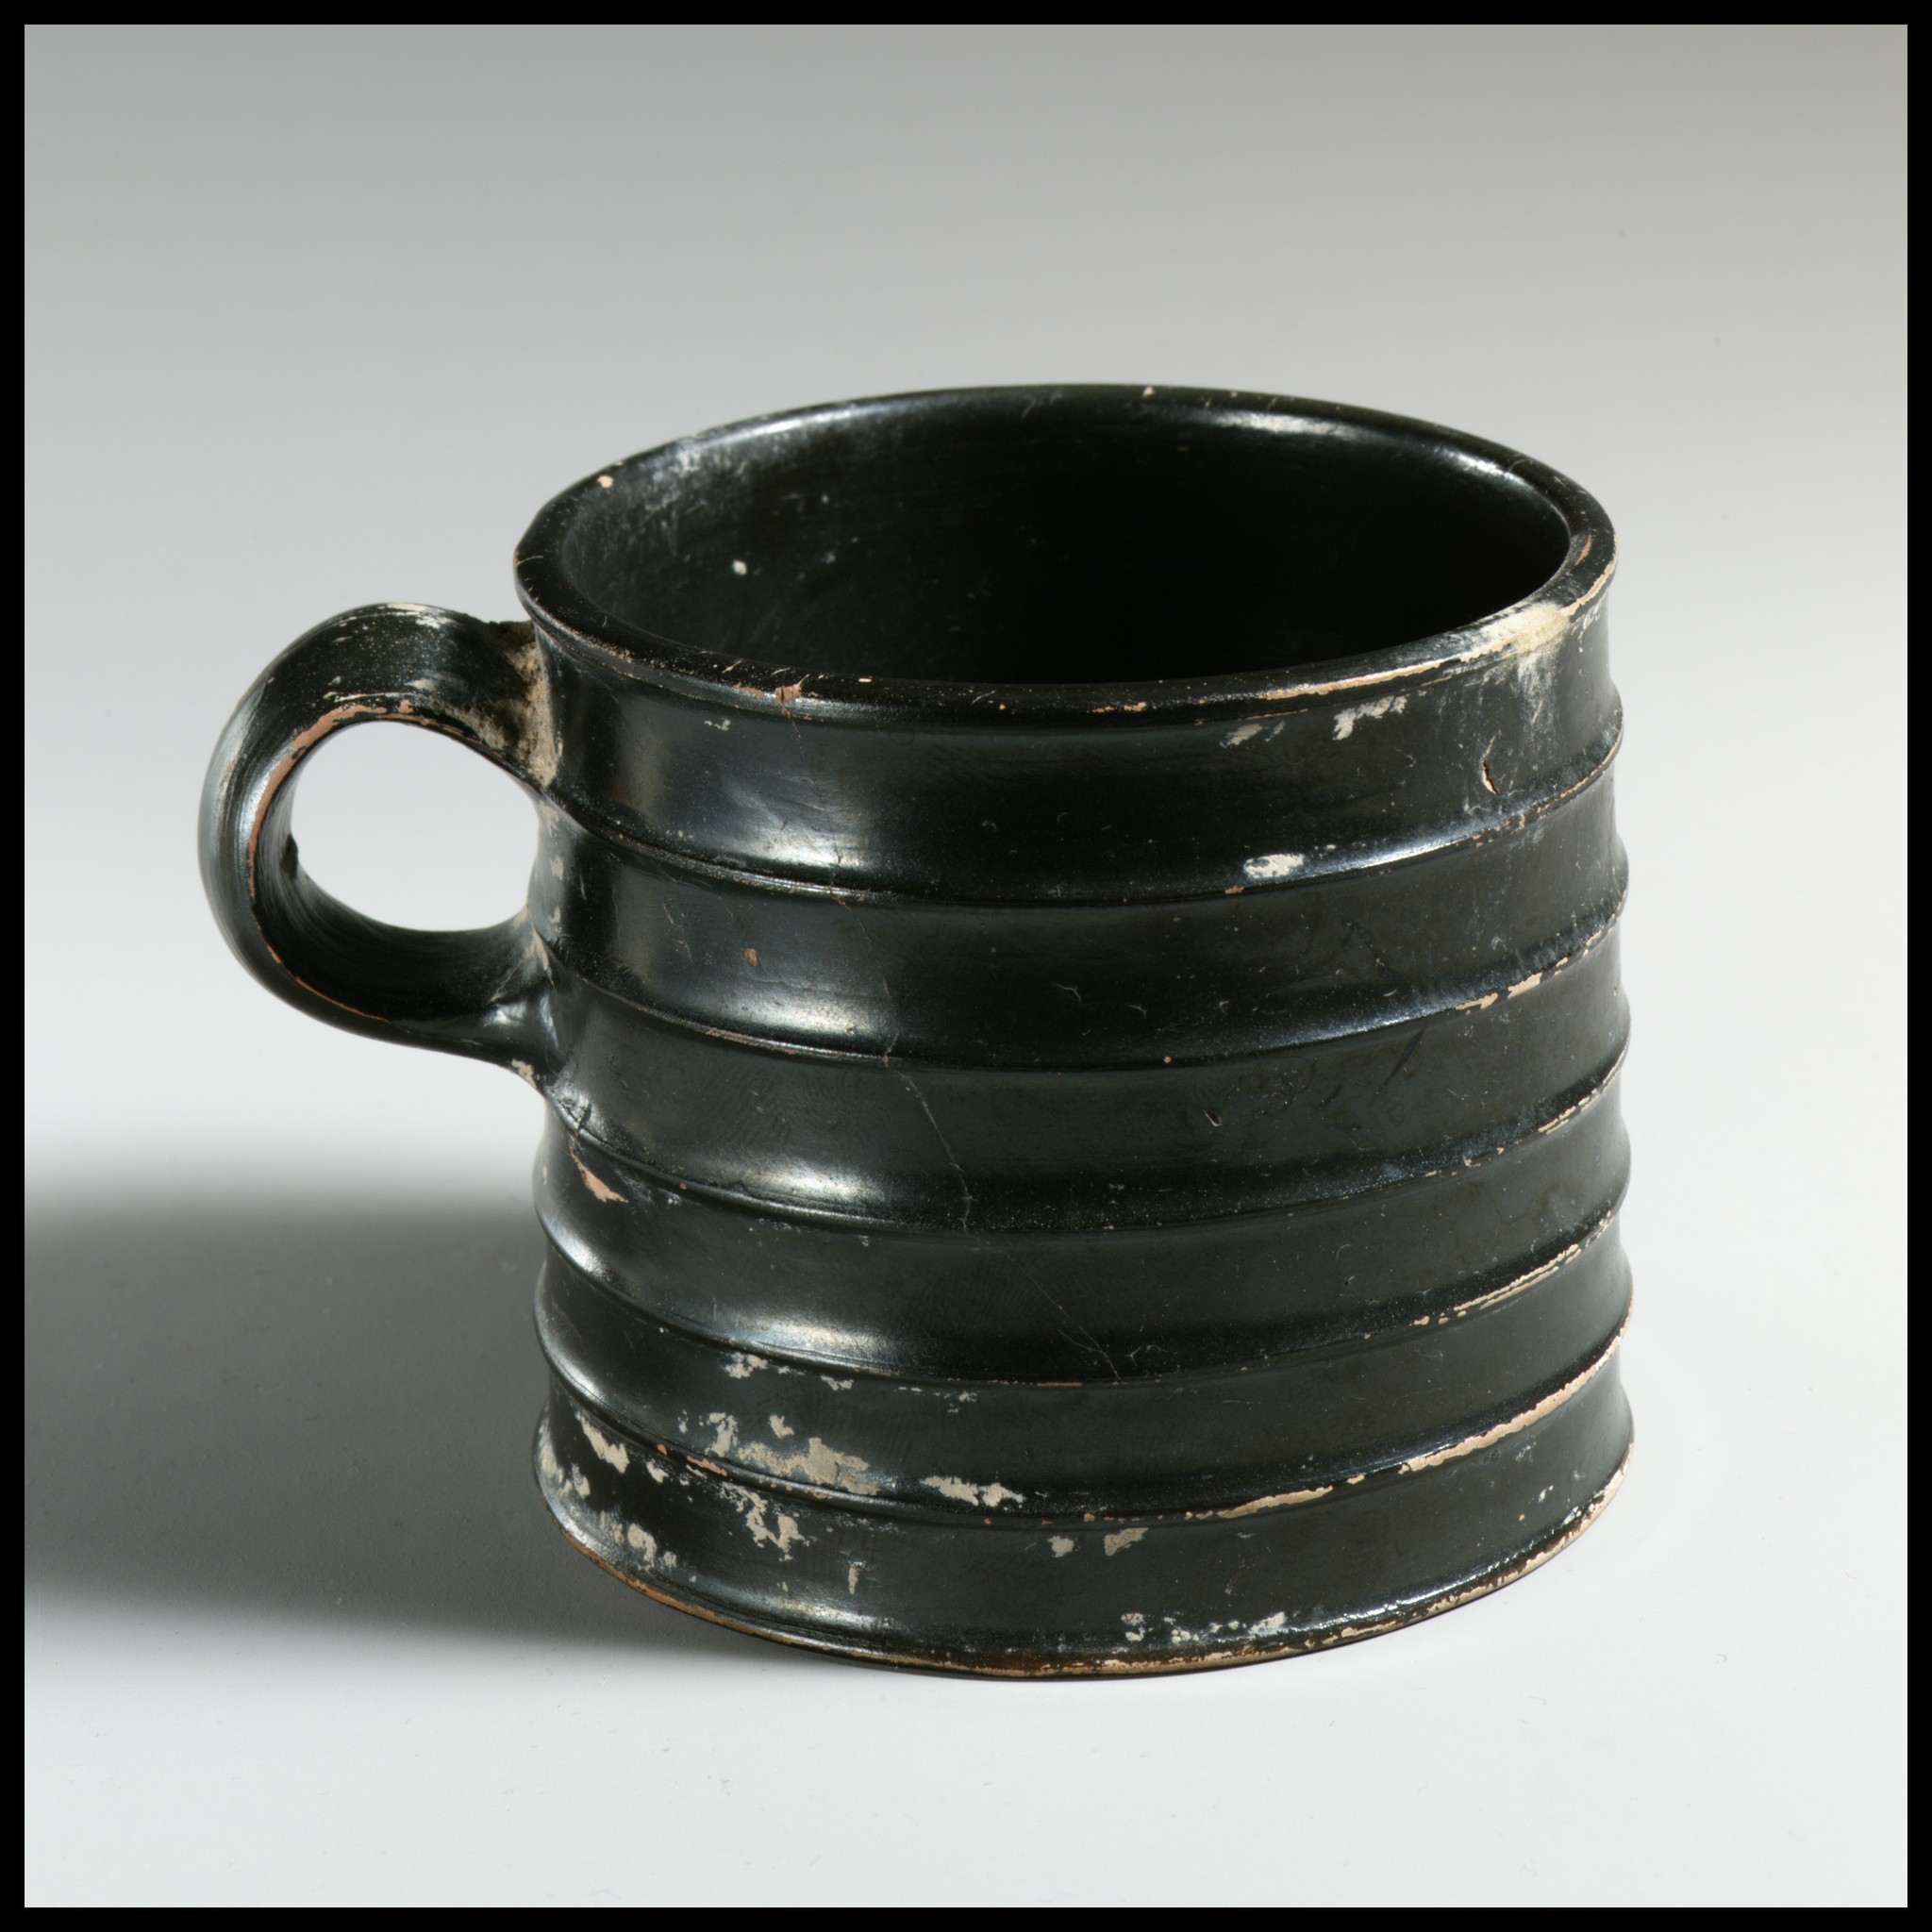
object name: mug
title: Terracotta mug with horizontal rills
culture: greek, south italian, apulian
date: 434-401 BCE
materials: terracotta